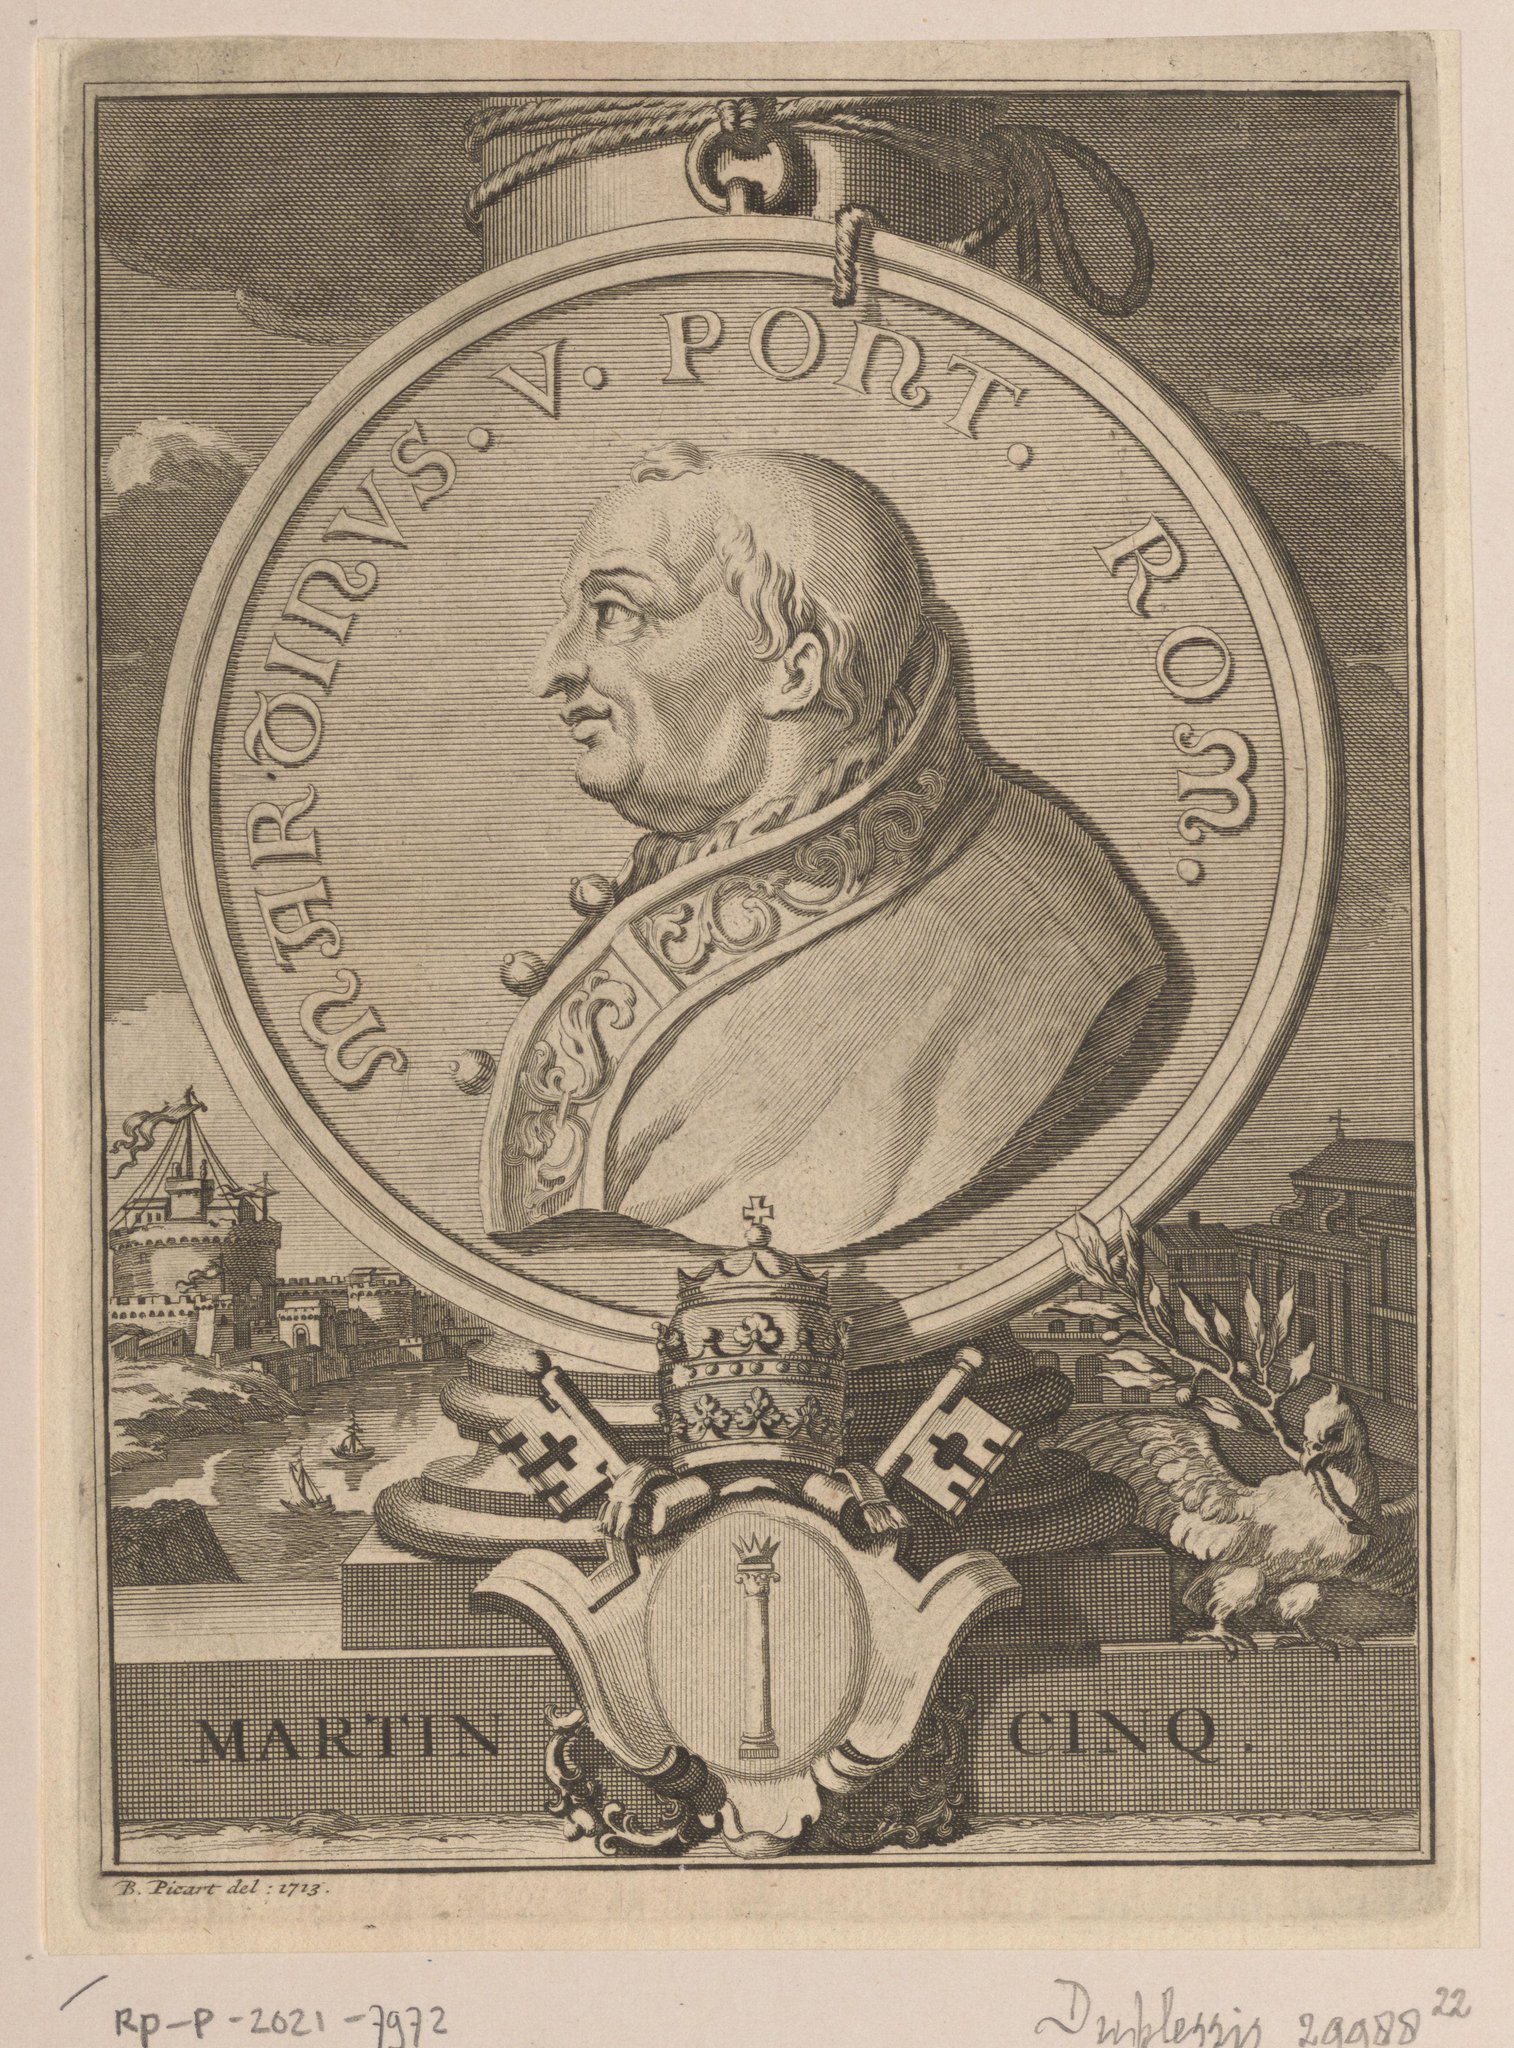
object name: book illustration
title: Penning met het portret van paus Martinus V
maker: bernard picart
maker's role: draughtsman, print maker, publisher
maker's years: 1673-1733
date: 1713-1715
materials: paper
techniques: etching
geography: amsterdam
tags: rome, historical persons, medal (considered as a piece of sculpture, regardless of its specific function), pope, armorial bearing, heraldry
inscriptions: collector's mark: Lugt 2228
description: Penning met het portret van paus Martinus V. Onderaan zijn wapenschild. Op de plint zit een duif met olijftak. Op de achtergrond links een gezicht op de Engelenburcht te Rome.